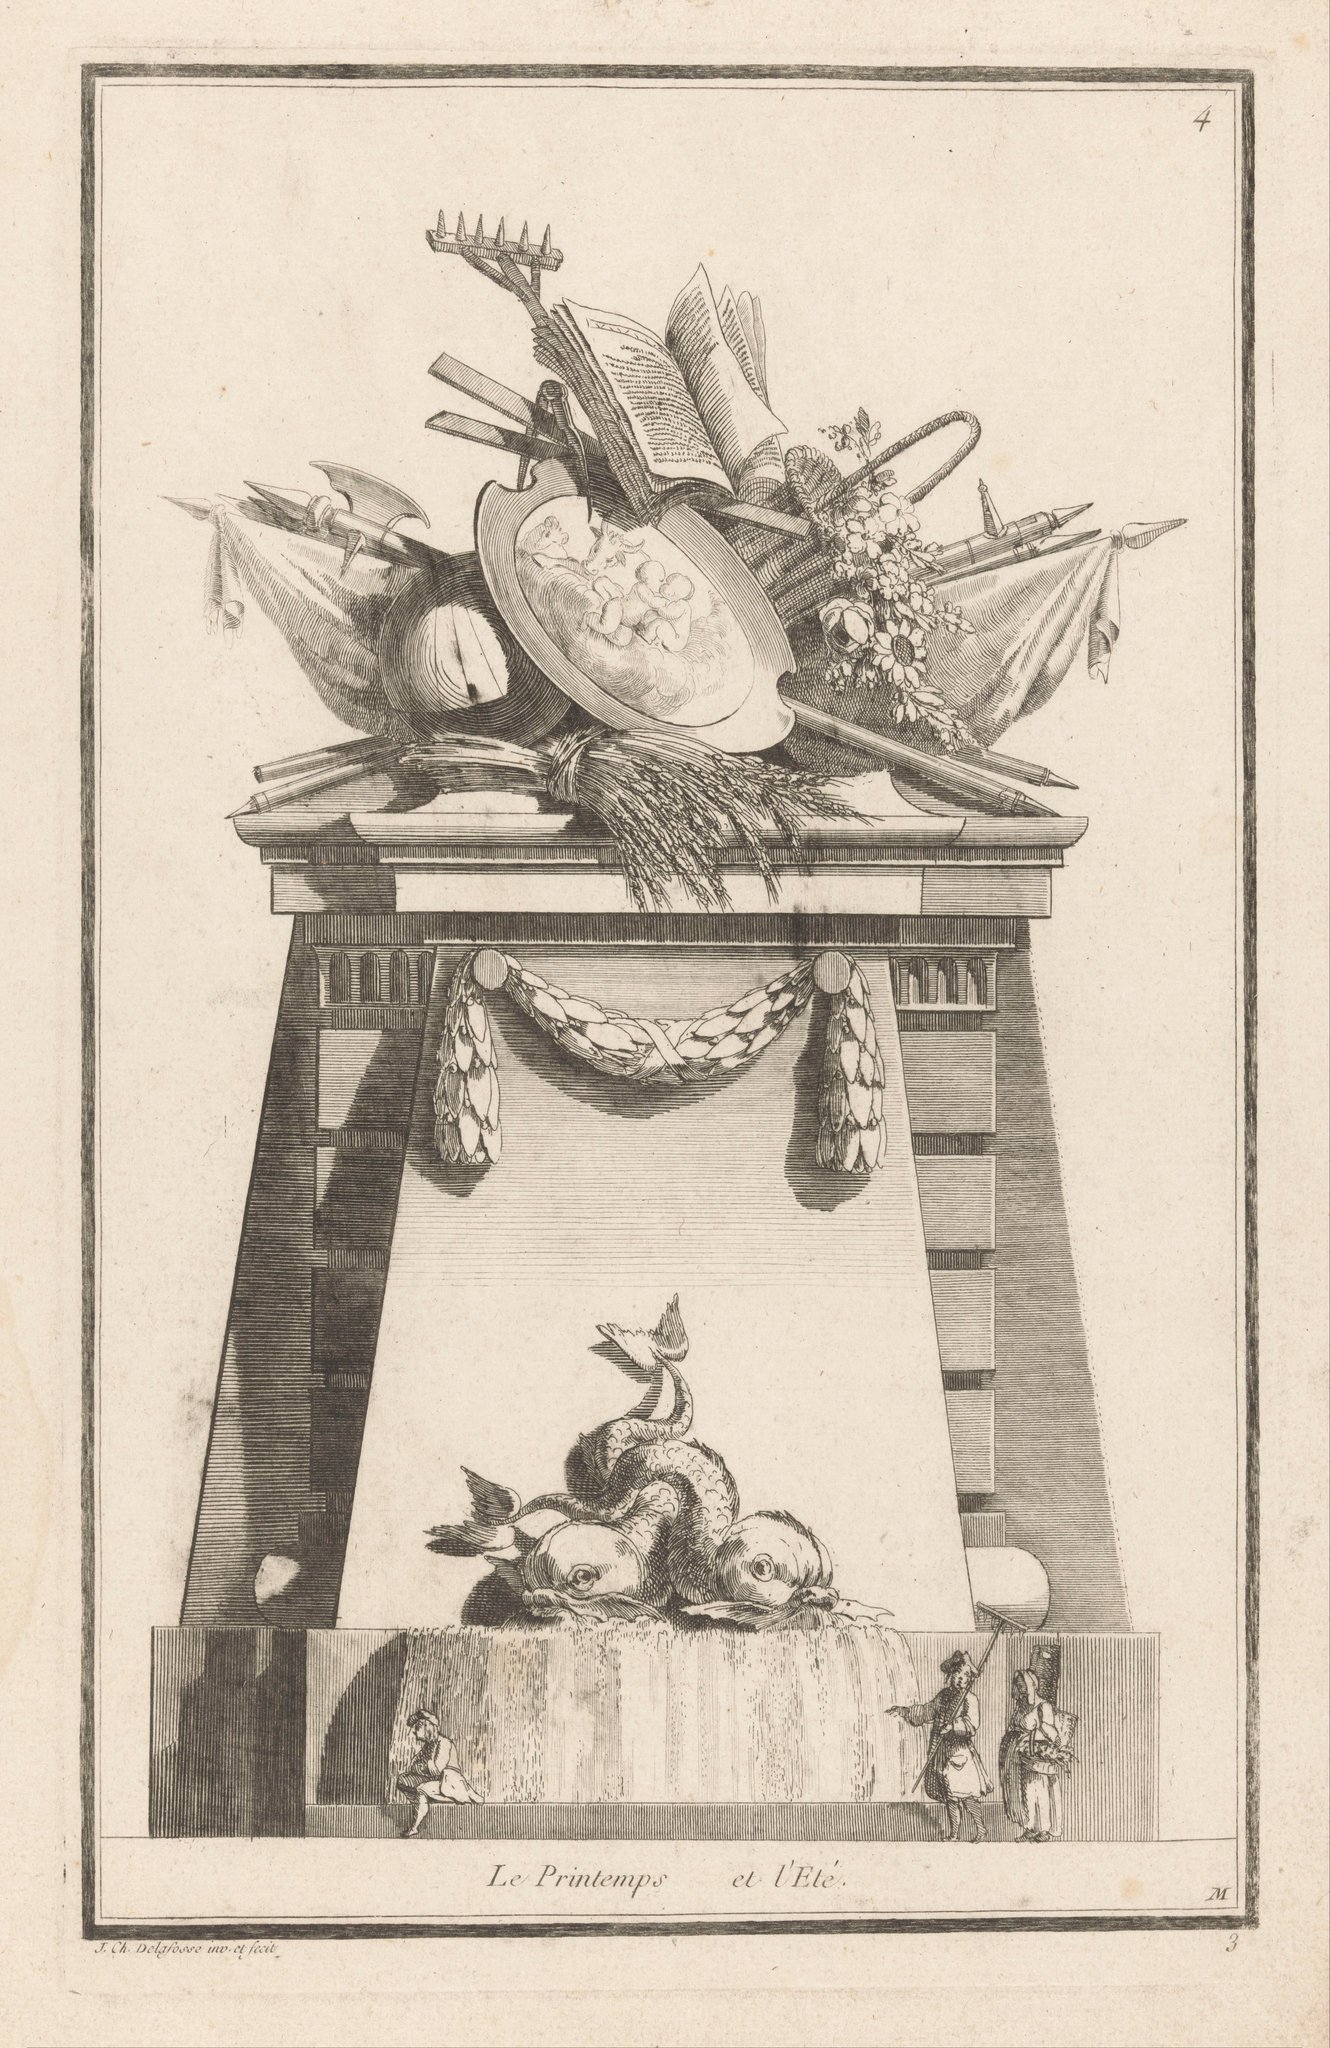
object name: print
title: Lente en zomer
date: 1768-1771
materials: paper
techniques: engraving, etching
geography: paris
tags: summer, 'aestas'; 'estate' (ripa), spring, 'ver'; 'primavera' (ripa), ornamental fountain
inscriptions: collector's mark: Lugt 2760, collector's mark: Lugt 2228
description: Drie figuren bevinden zich voor een fontein met twee dolfijnen. Aan de bovenzijde wapens, een boek, korenaren, een mand met bloemen en een schild met putti en runderen. Prentnummer 4.